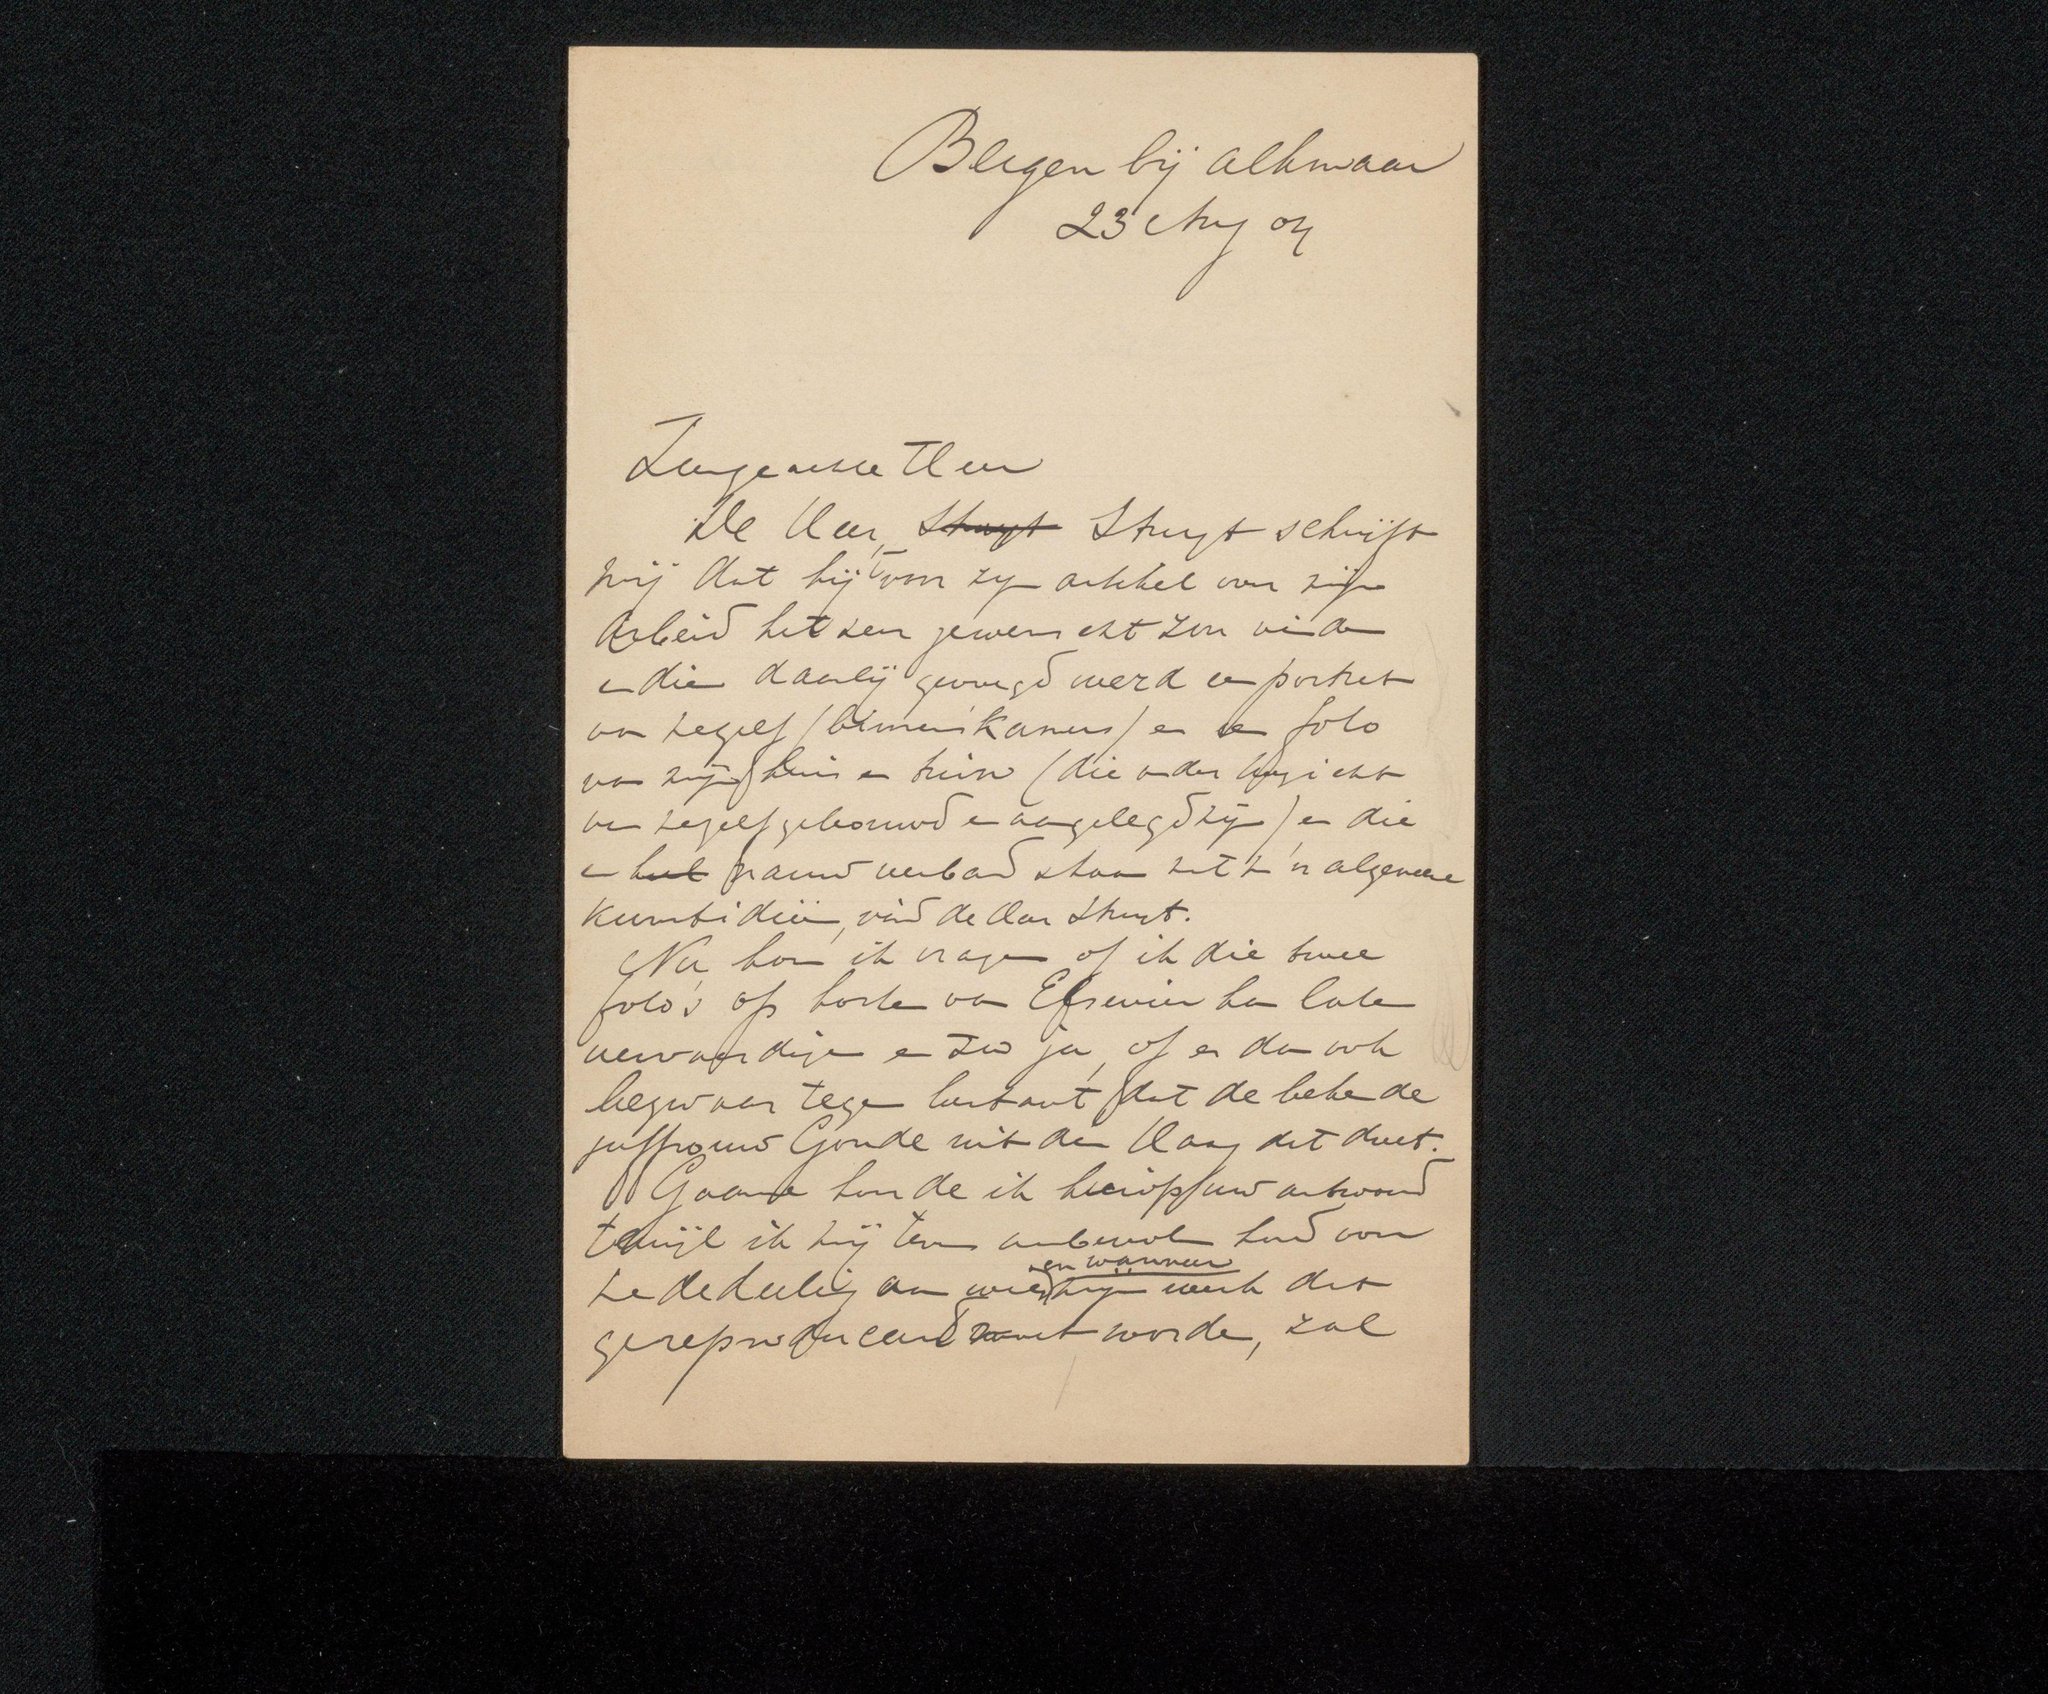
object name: letter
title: Brief aan Philip Zilcken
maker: jacobus gerardus veldheer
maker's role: draughtsman, print maker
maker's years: 1866-1954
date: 1904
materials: ink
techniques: pen, writing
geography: bergen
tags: the hague, painter, philip zilcken, photography, cinematography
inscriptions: collector's mark: ‘RPK’